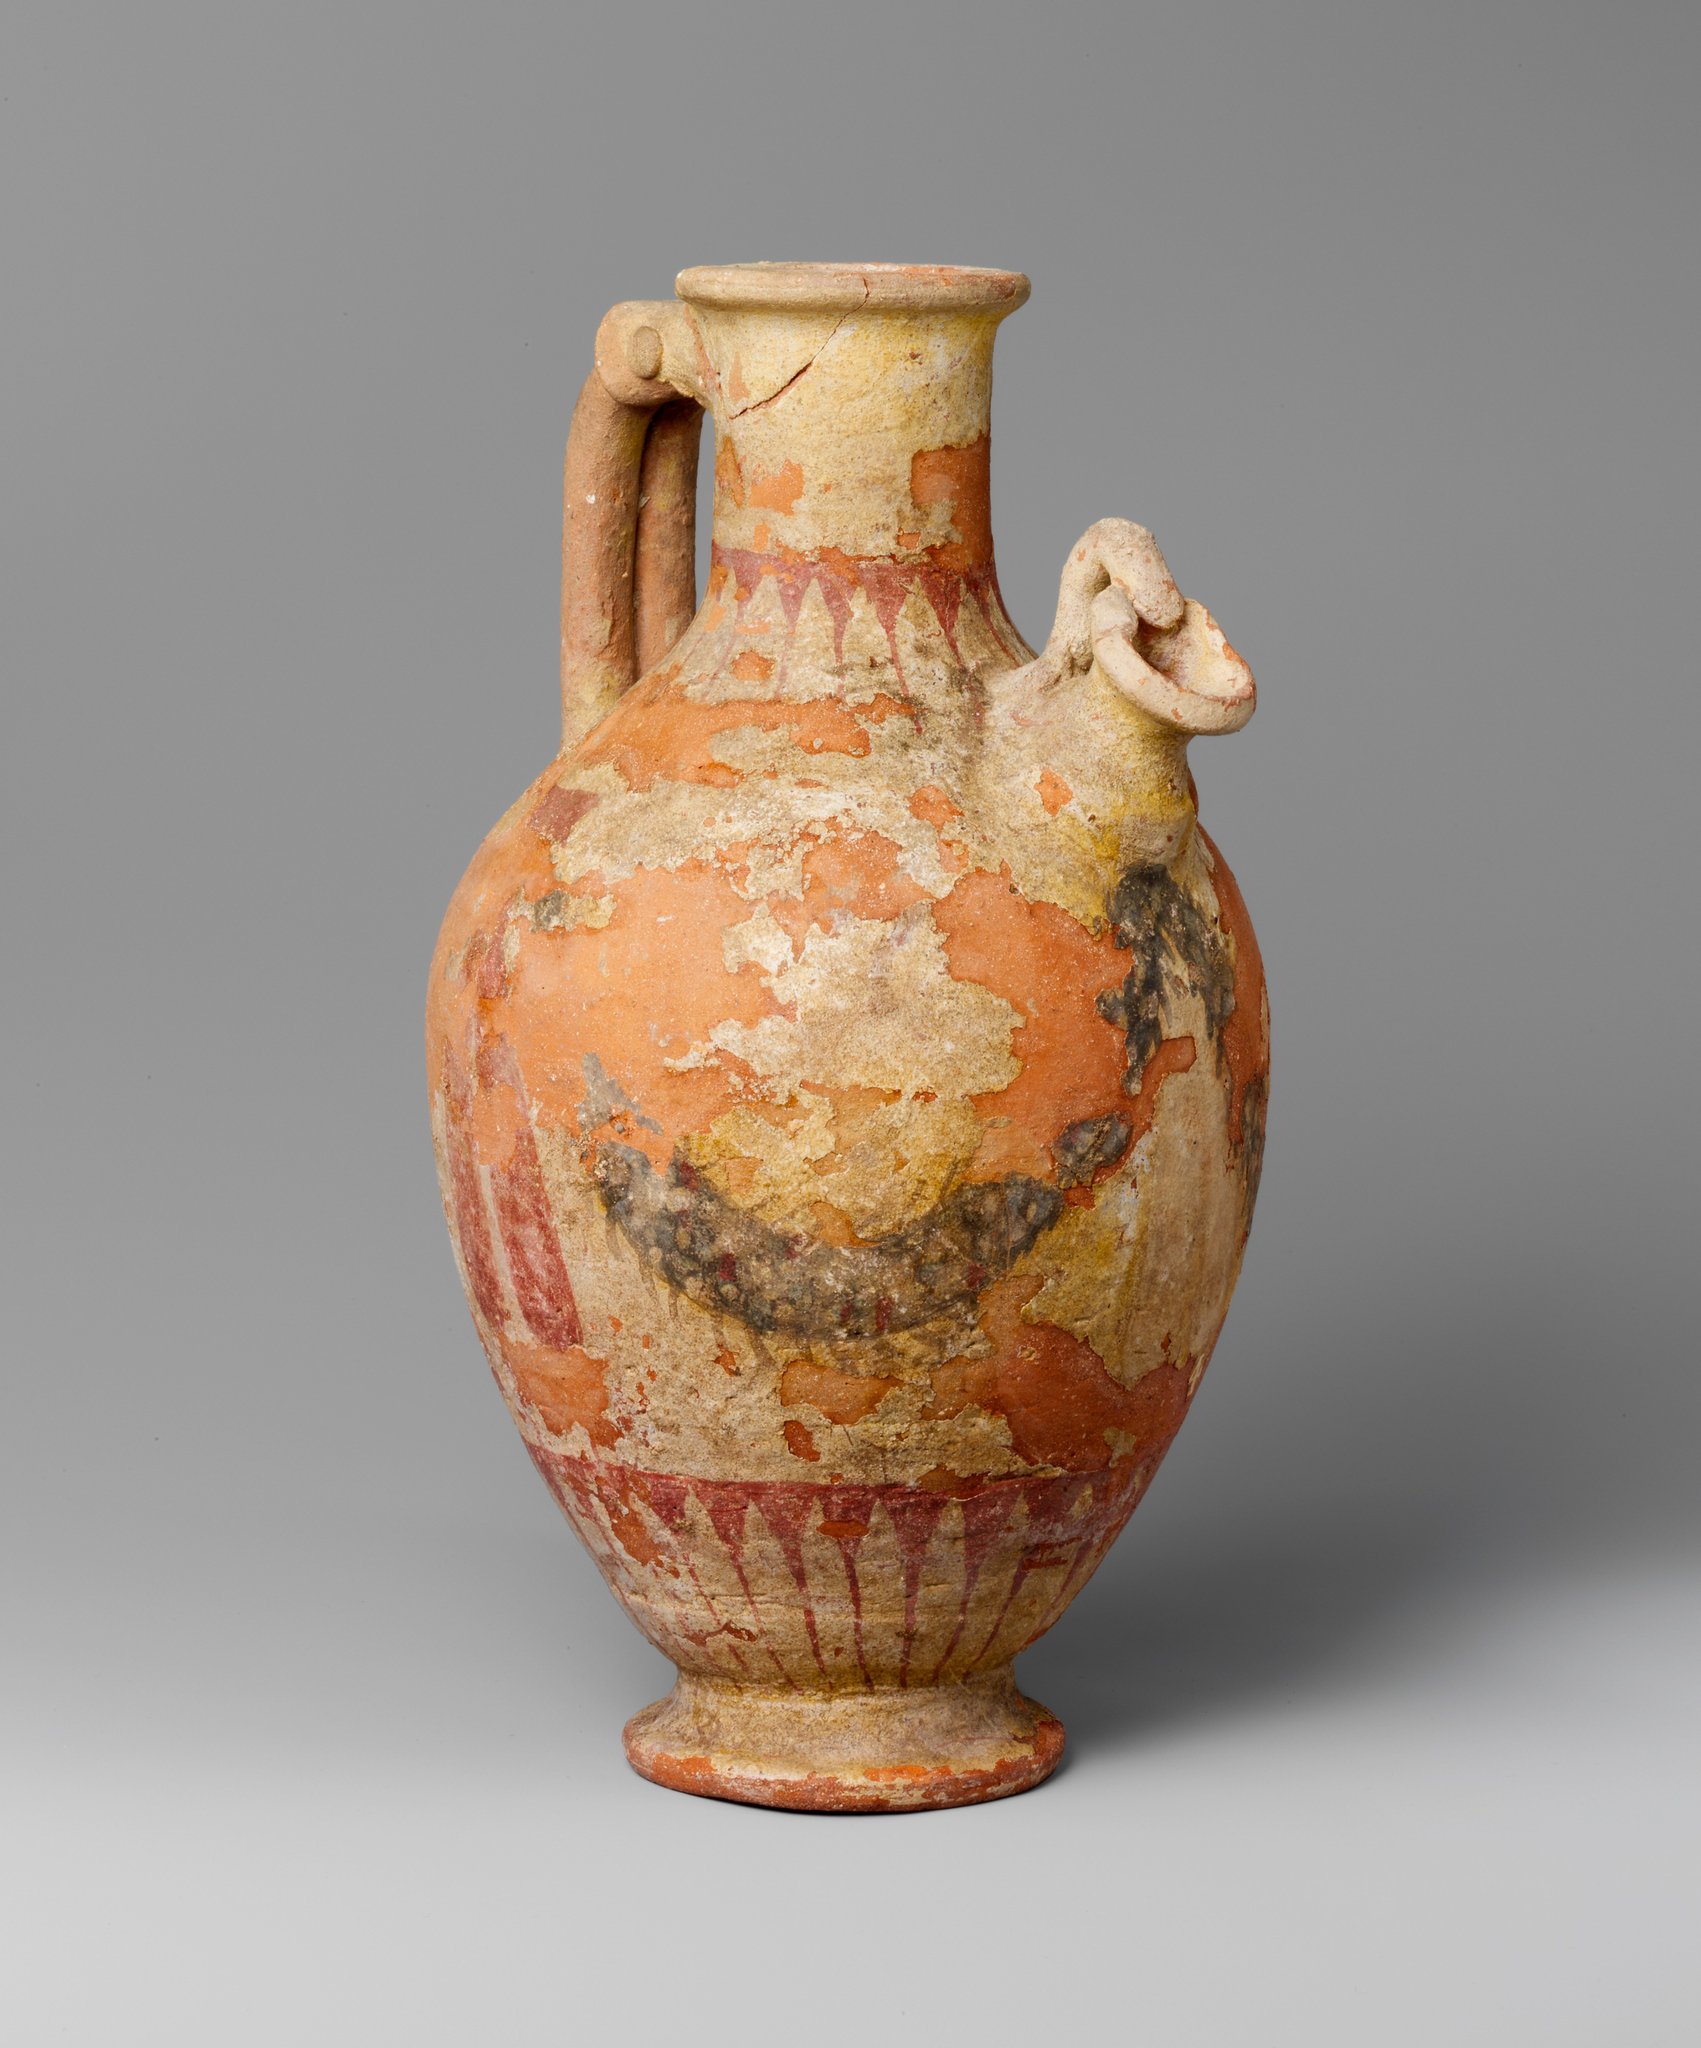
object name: jug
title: Terracotta jug with a pitcher-spout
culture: cypriot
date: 310-150 BCE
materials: terracotta